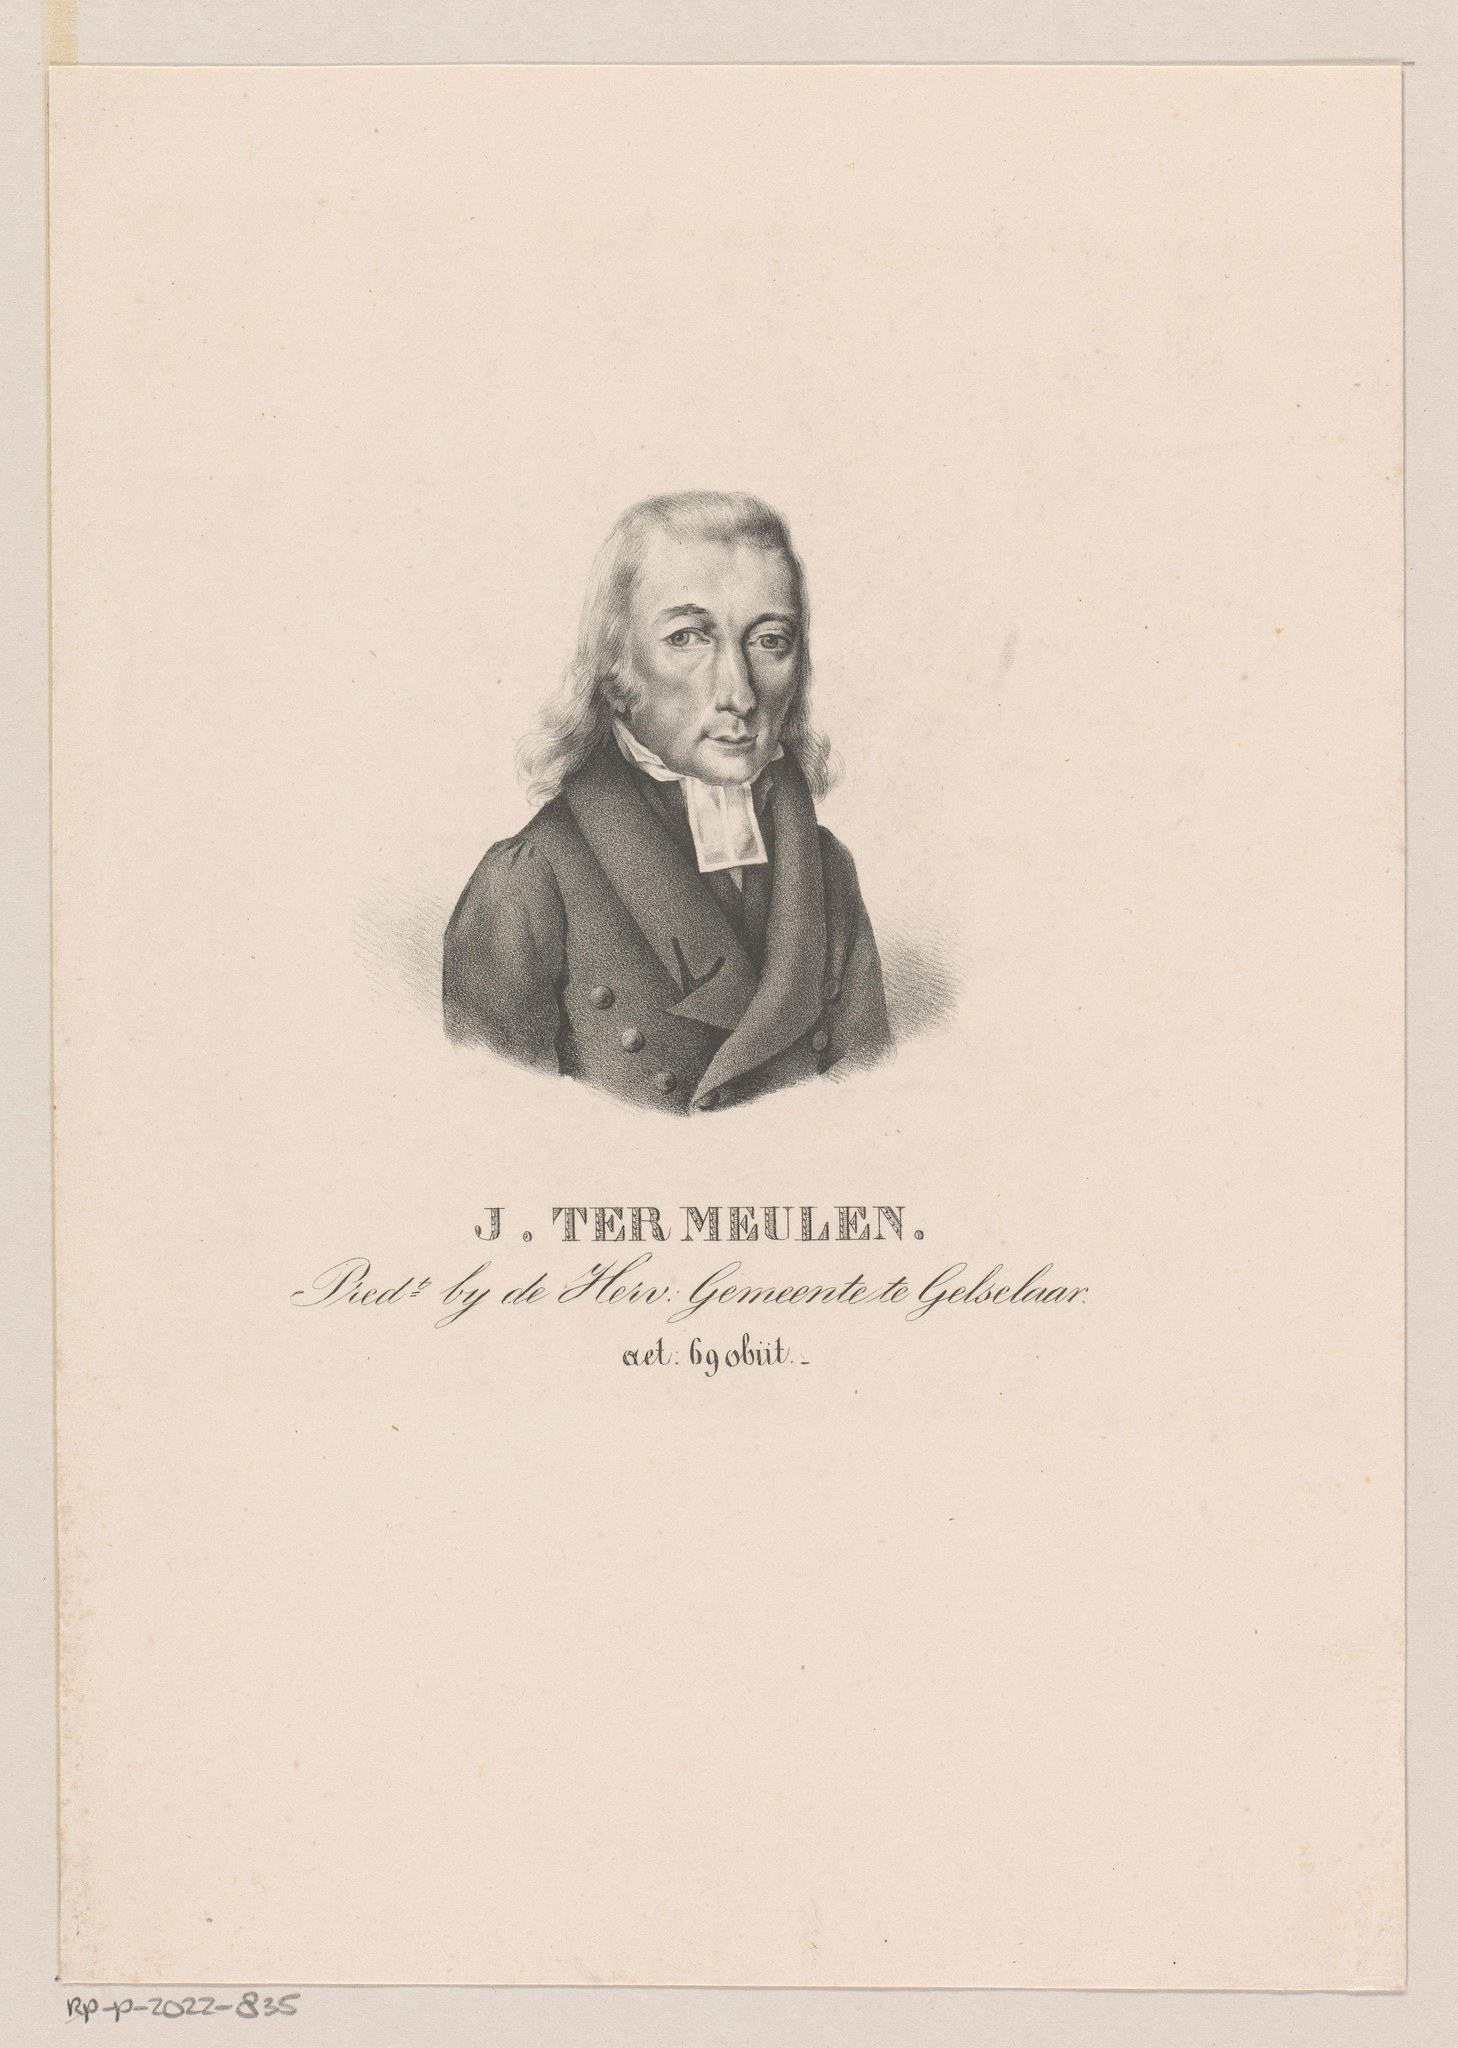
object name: print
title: J. ter Meulen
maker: Anonymous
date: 1837-1900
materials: paper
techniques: lithograph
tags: historical persons, functionaries and dignitaries ~ protestant churches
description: Met eenregelig onderschrift in het Nederlands.